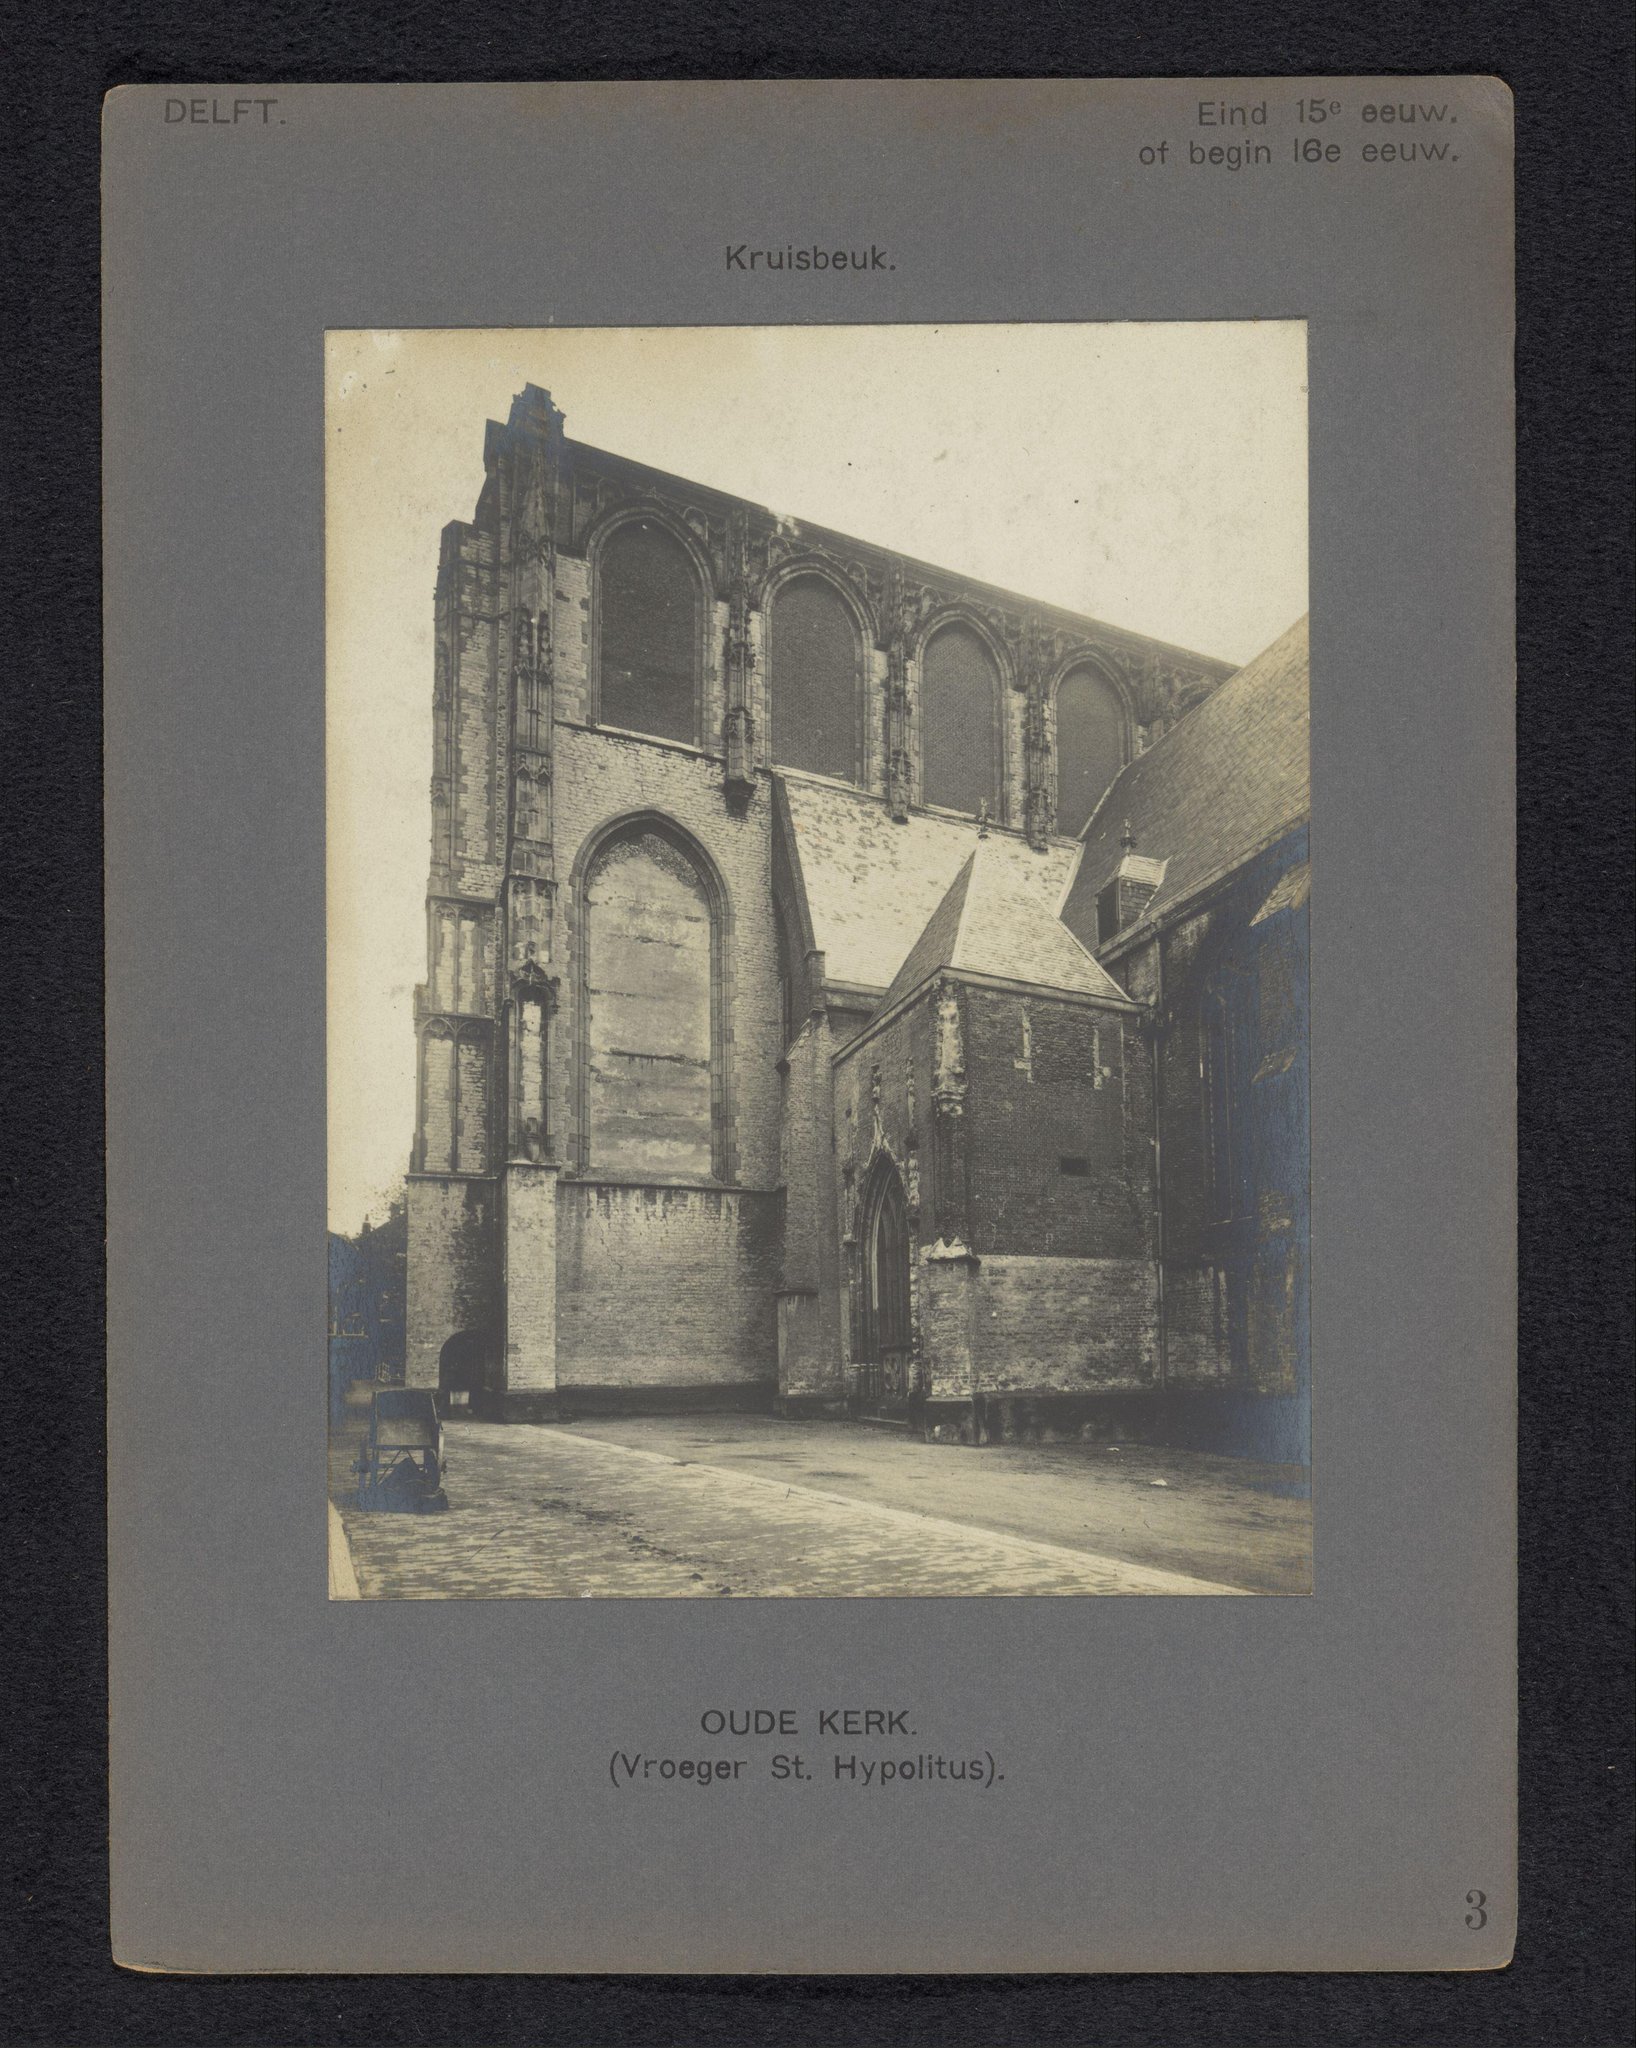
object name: photograph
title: Gezicht op het transept van de Oude Kerk in Delft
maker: Anonymous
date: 1900-1904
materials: cardboard, photographic support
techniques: gelatin silver print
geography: delft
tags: parts of church exterior and annexes: transept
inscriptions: number: ‘3’, inscription: ‘Delft. Eind 15e eeuw. of begin 16e eeuw.’, inscription: ‘Het recht van reproductie dezer photo's wordt door den Uitgever voorbehouden.’